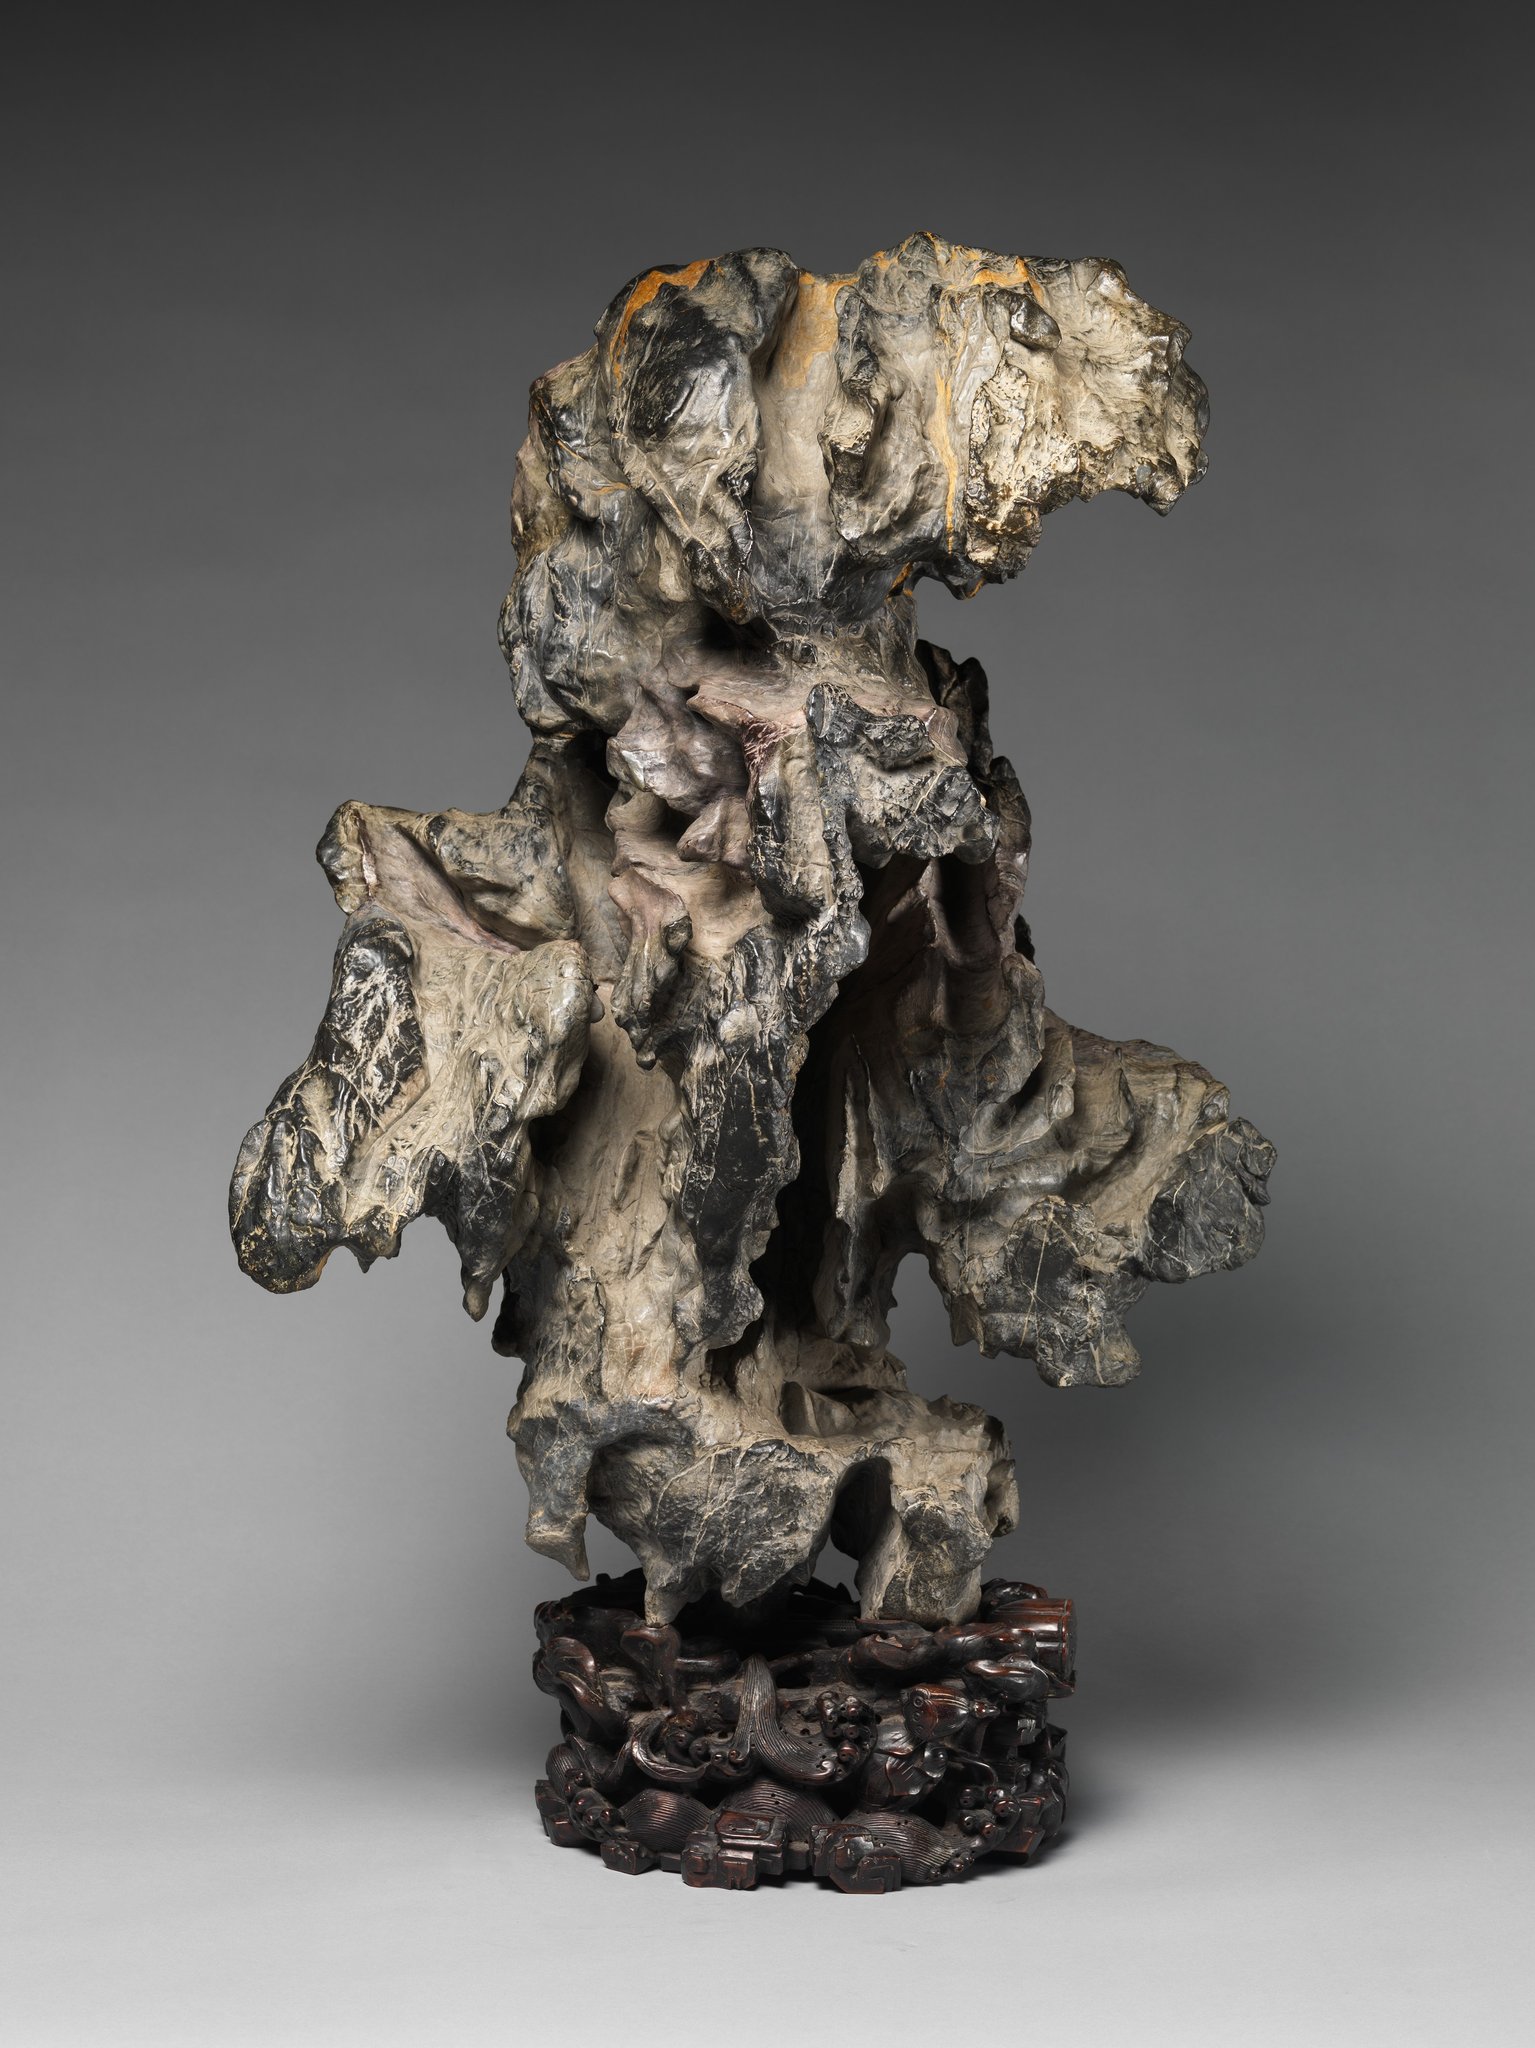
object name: scholar's rock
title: Rock in the form of a fantastic mountain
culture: chinese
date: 1701-1800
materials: limestone, wood